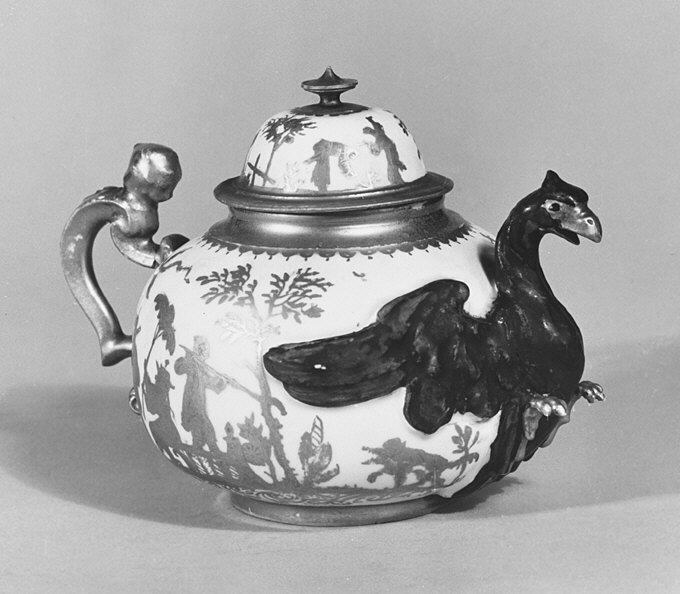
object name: teapot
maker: meissen manufactory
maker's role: manufactory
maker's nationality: german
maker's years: 1710-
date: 1701-1800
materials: hard paste porcelain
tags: human figures,birds,trees